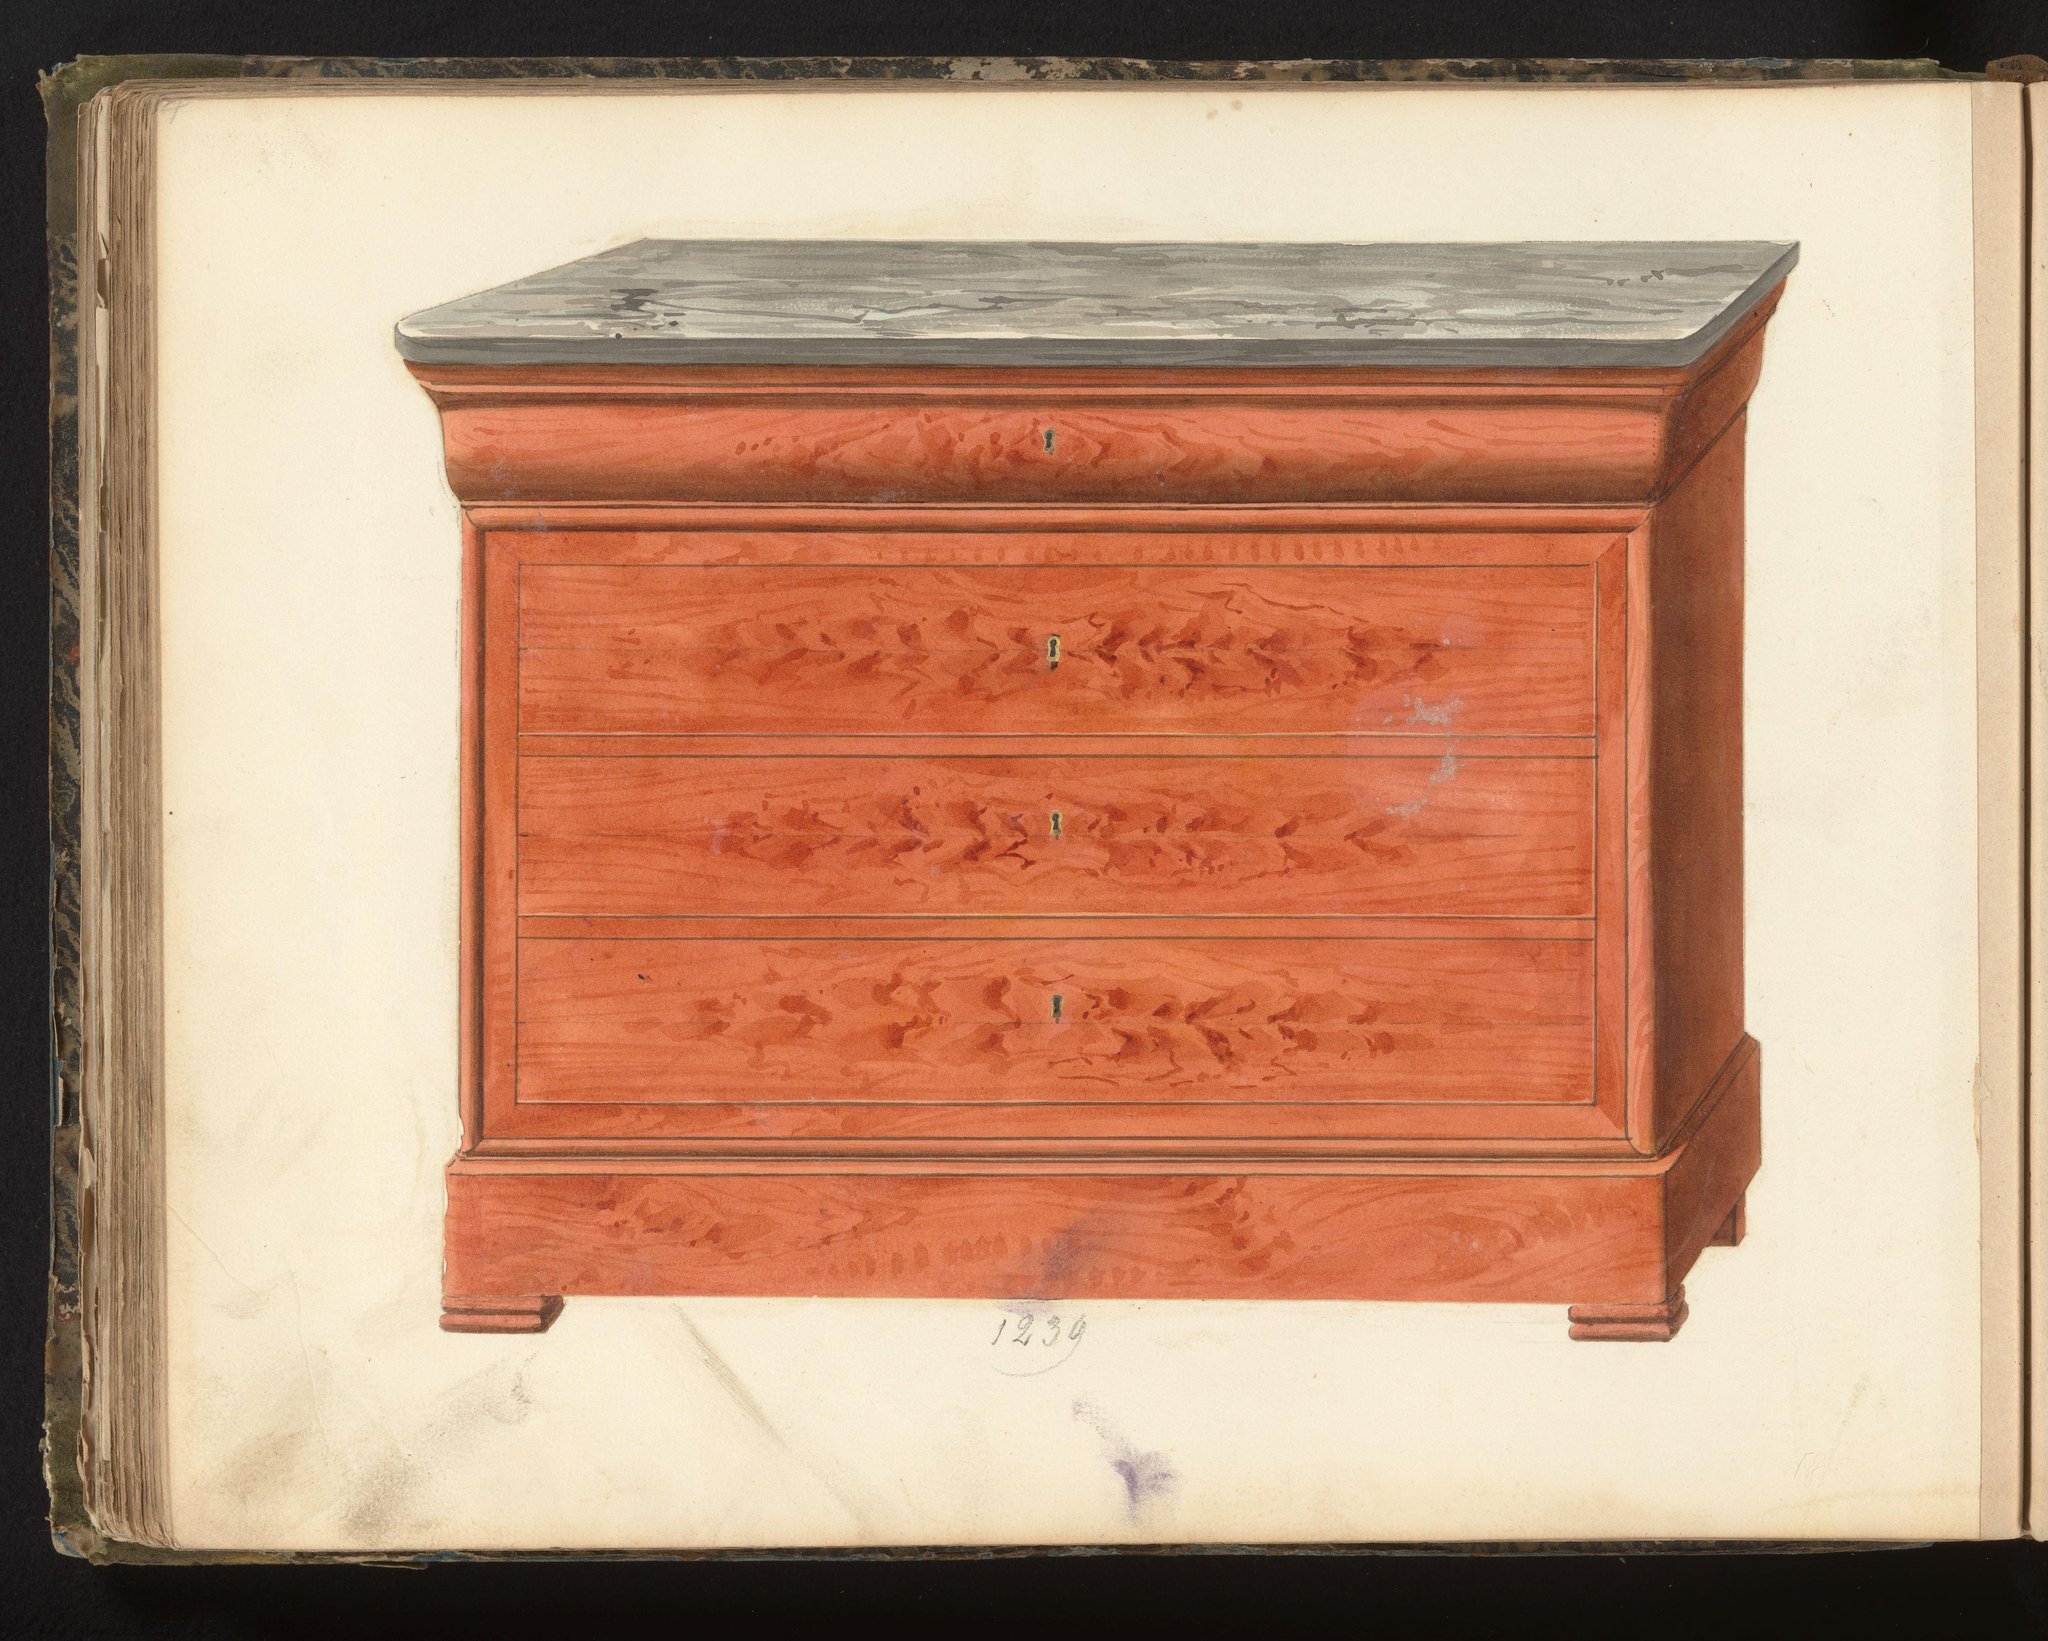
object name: album leaf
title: Ontwerp voor een secretaire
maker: Anonymous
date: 1825-1839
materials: ink, paper, pencil, watercolor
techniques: brush, pen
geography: paris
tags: cupboard (+ wood and other phytogenic material)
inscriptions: inscription: ‘1239 Commode & secretaire à boudin’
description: Ontwerp voor een secretaire/commode met marmeren blad, in dichte toestand. Het blad op de achterzijde genummerd: 78, het tegenoverliggende blad met informatie over de afgebeelde meubelen genummerd: 78 bis. Onderdeel van een album met 80 bladen met tekeningen en een prent van gefineerde en gelakte meubelen, alsmede zitmeubelen.